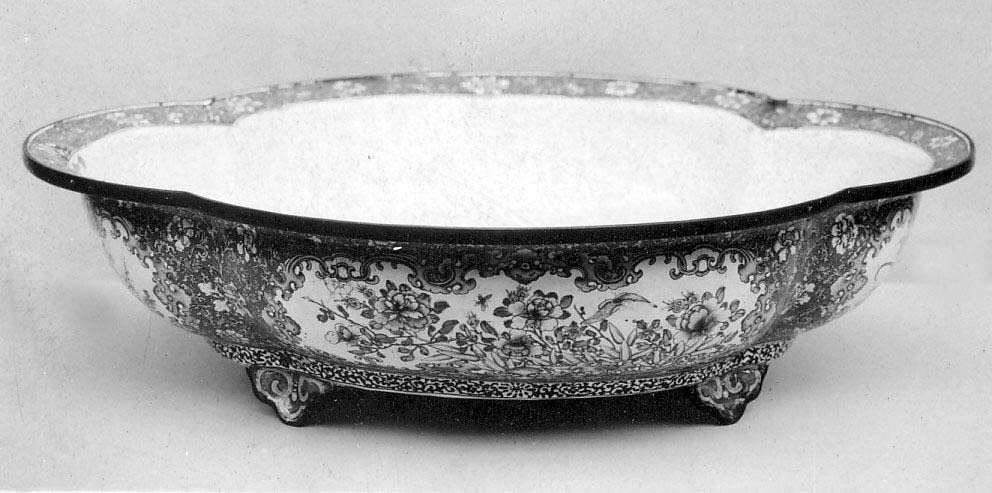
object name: jardinière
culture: chinese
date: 1701-1800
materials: enamel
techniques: painting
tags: flowers